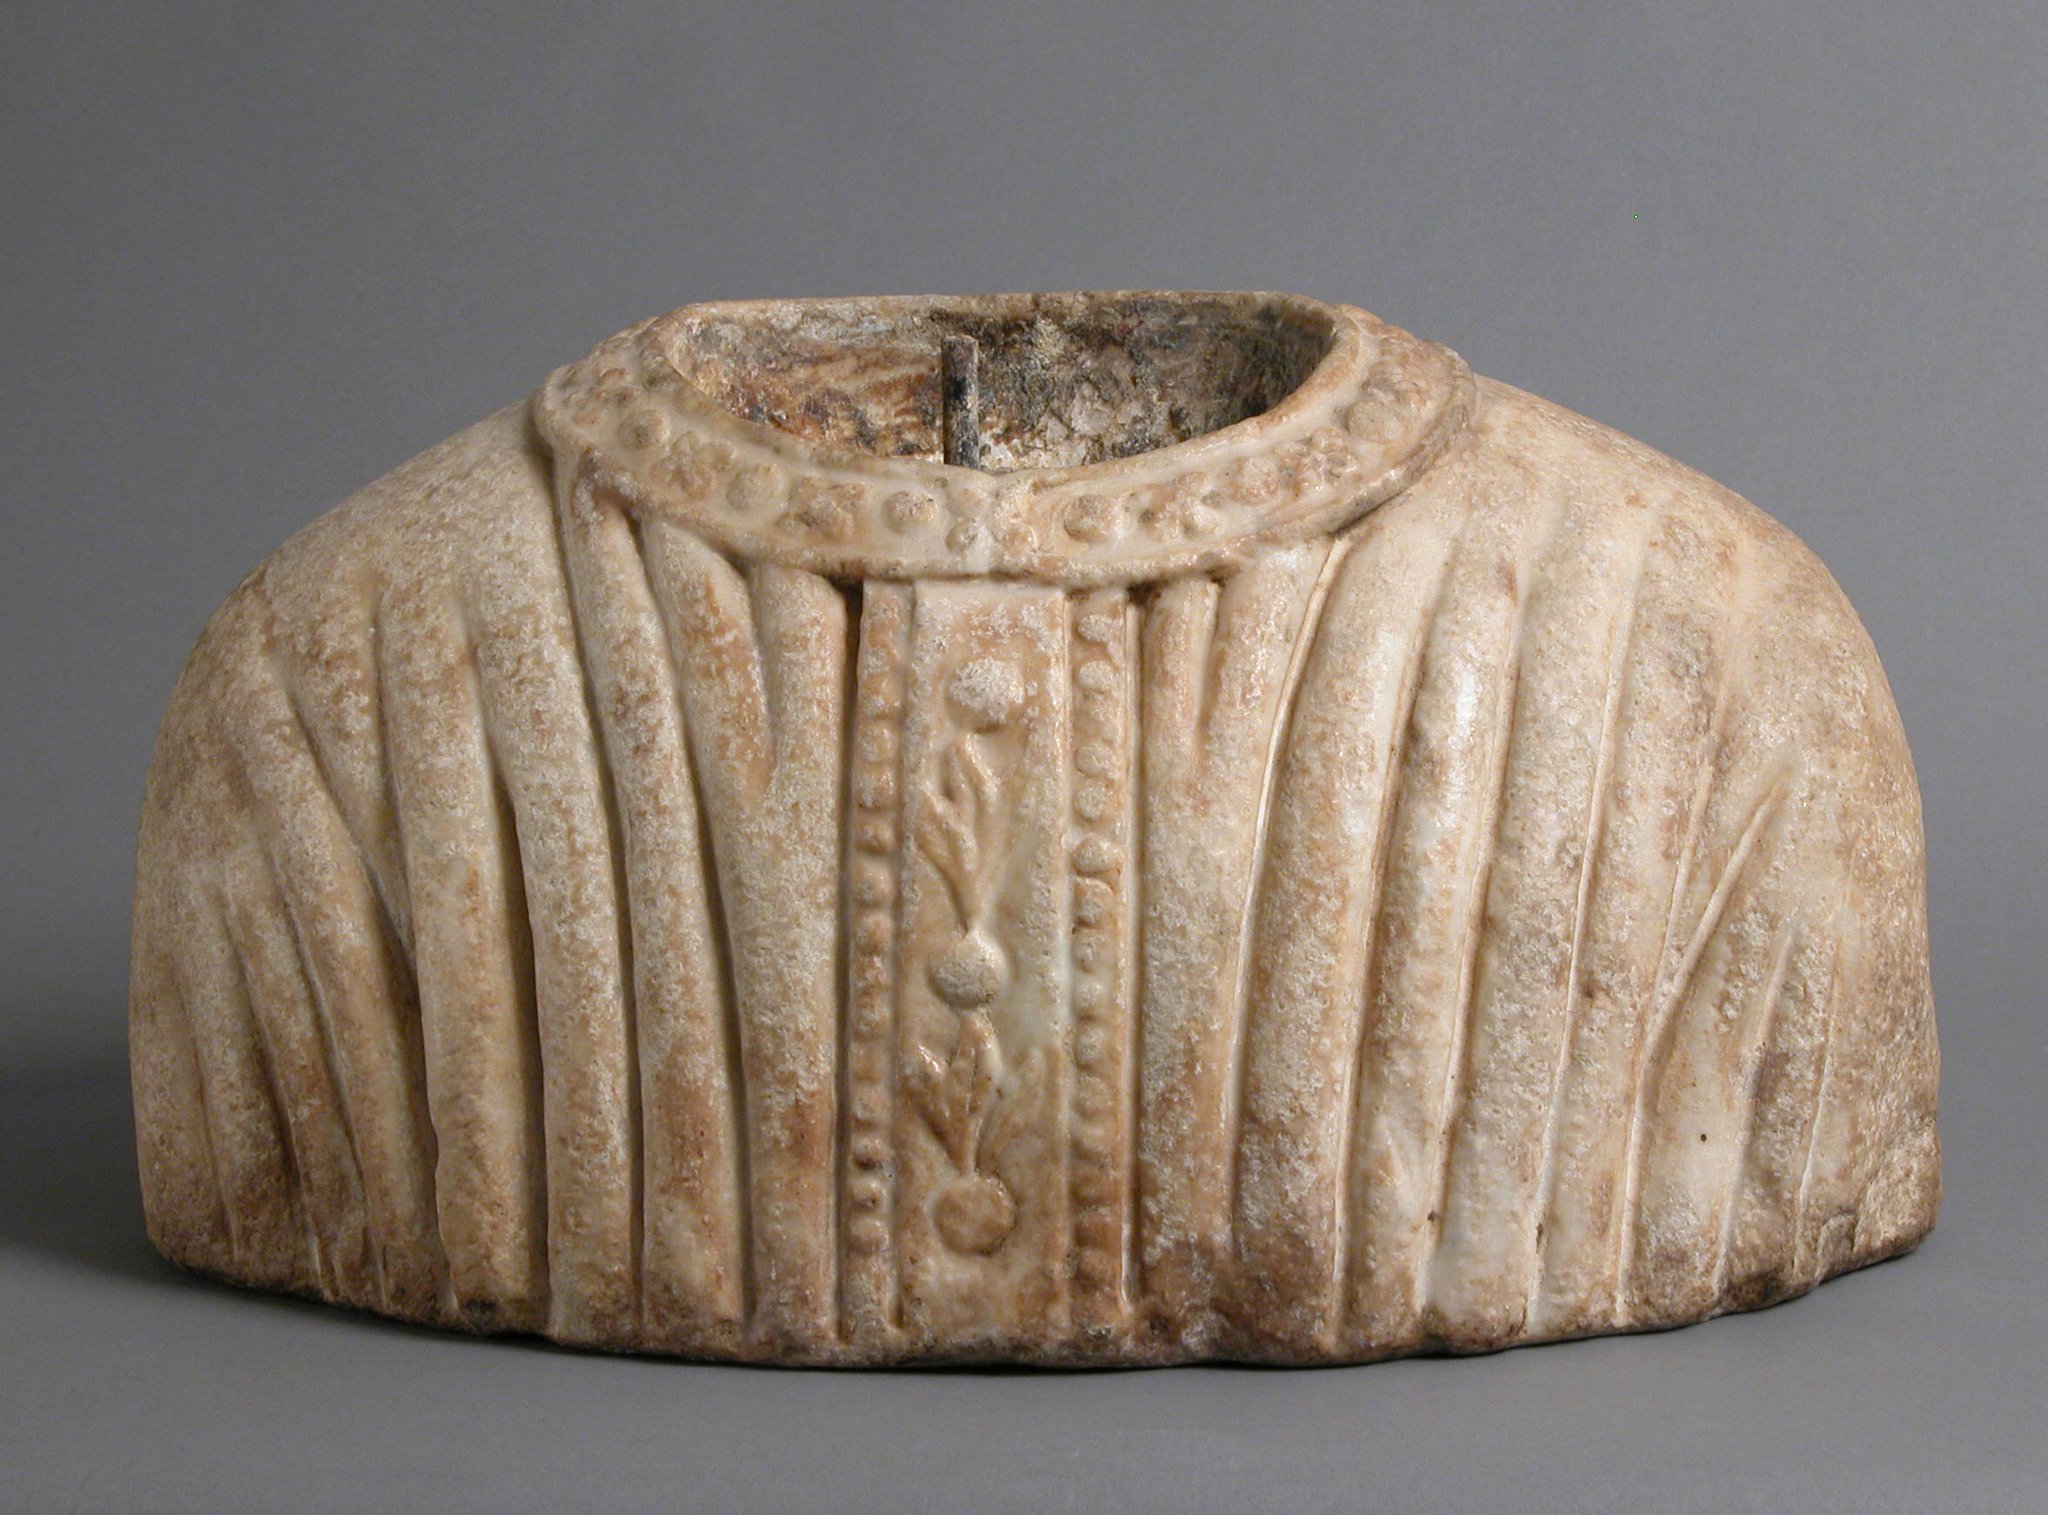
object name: bust fragment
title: Shoulders from Portrait Bust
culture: italian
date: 1401-1500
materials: marble